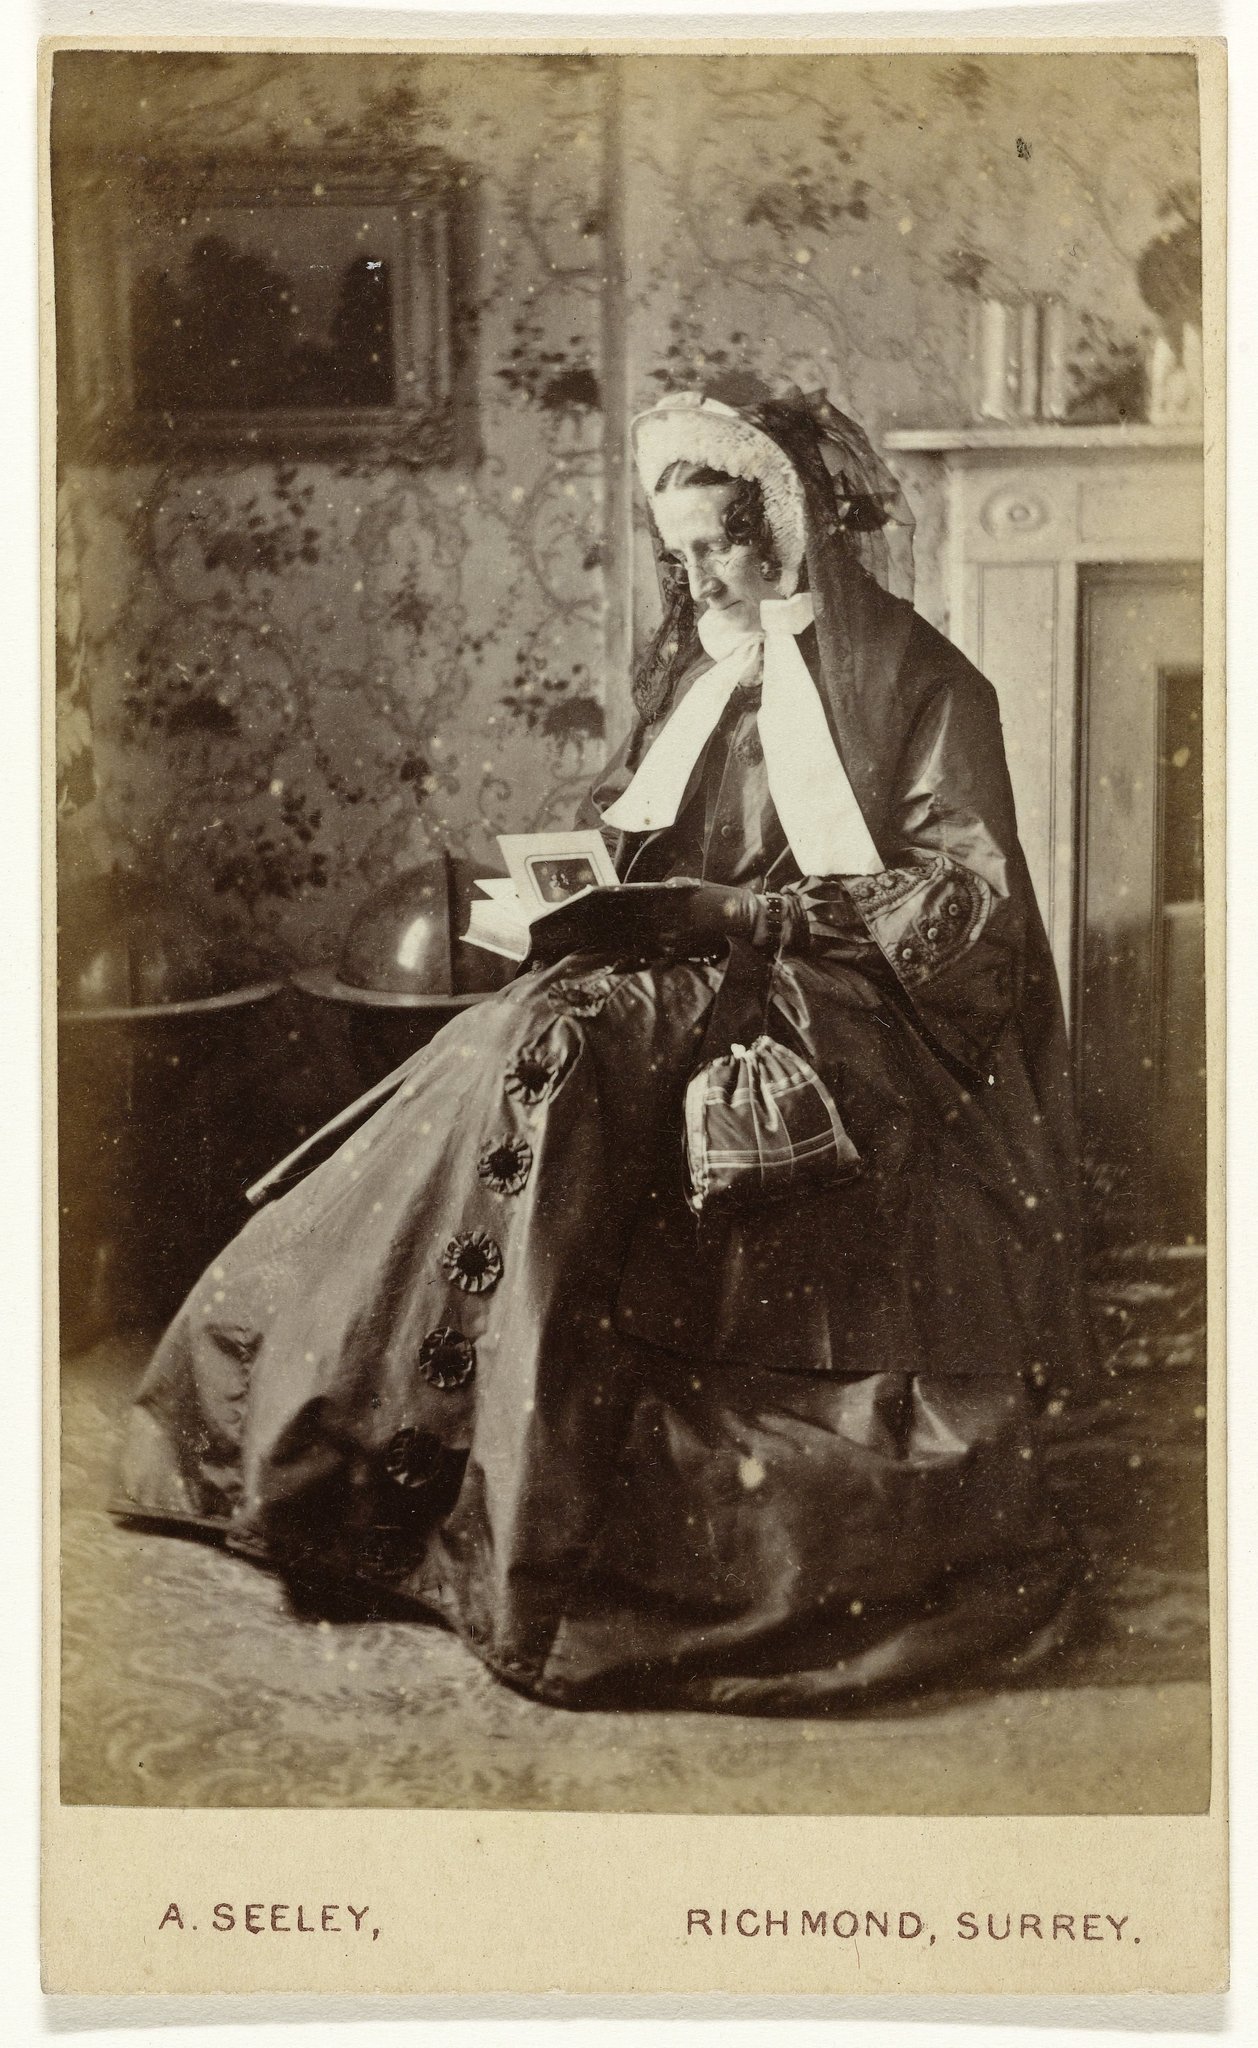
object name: carte de visite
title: Cartes-de-visite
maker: alfred seeley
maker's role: fotograaf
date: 1878-1891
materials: cardboard, paper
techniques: albumen print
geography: richmond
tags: photograph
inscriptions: annotation: ‘PHOTOGRAPHER / AND / PORTRAIT PAINTER / ALFRED SEELEY / Onslow Road / RICHMOND HILL / SURREY / VIEWS AND GROUPS PHOTOGRAPHED / IN ANY PART OF THE COUNTRY / THIS OR ANY PICTURE ENLARGED TO ANY SIZE / AND PAINTED IN OIL OR WATER COLORS / Marion, Imp. Paris’, annotation: ‘A. SEELEY, / RICHMOND, SURREY.’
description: Cartomanie was a collecting craze. From 1855 hundreds of thousands of these portraits were annually sold worldwide. People had photographs taken of their loved ones, including their pets, and kept them in an album. Portraits of kings, writers, artists, actors, and statesmen were also collected. Photography was no longer the preserve of the wealthy; farmers and maidservants now also stood before the camera.